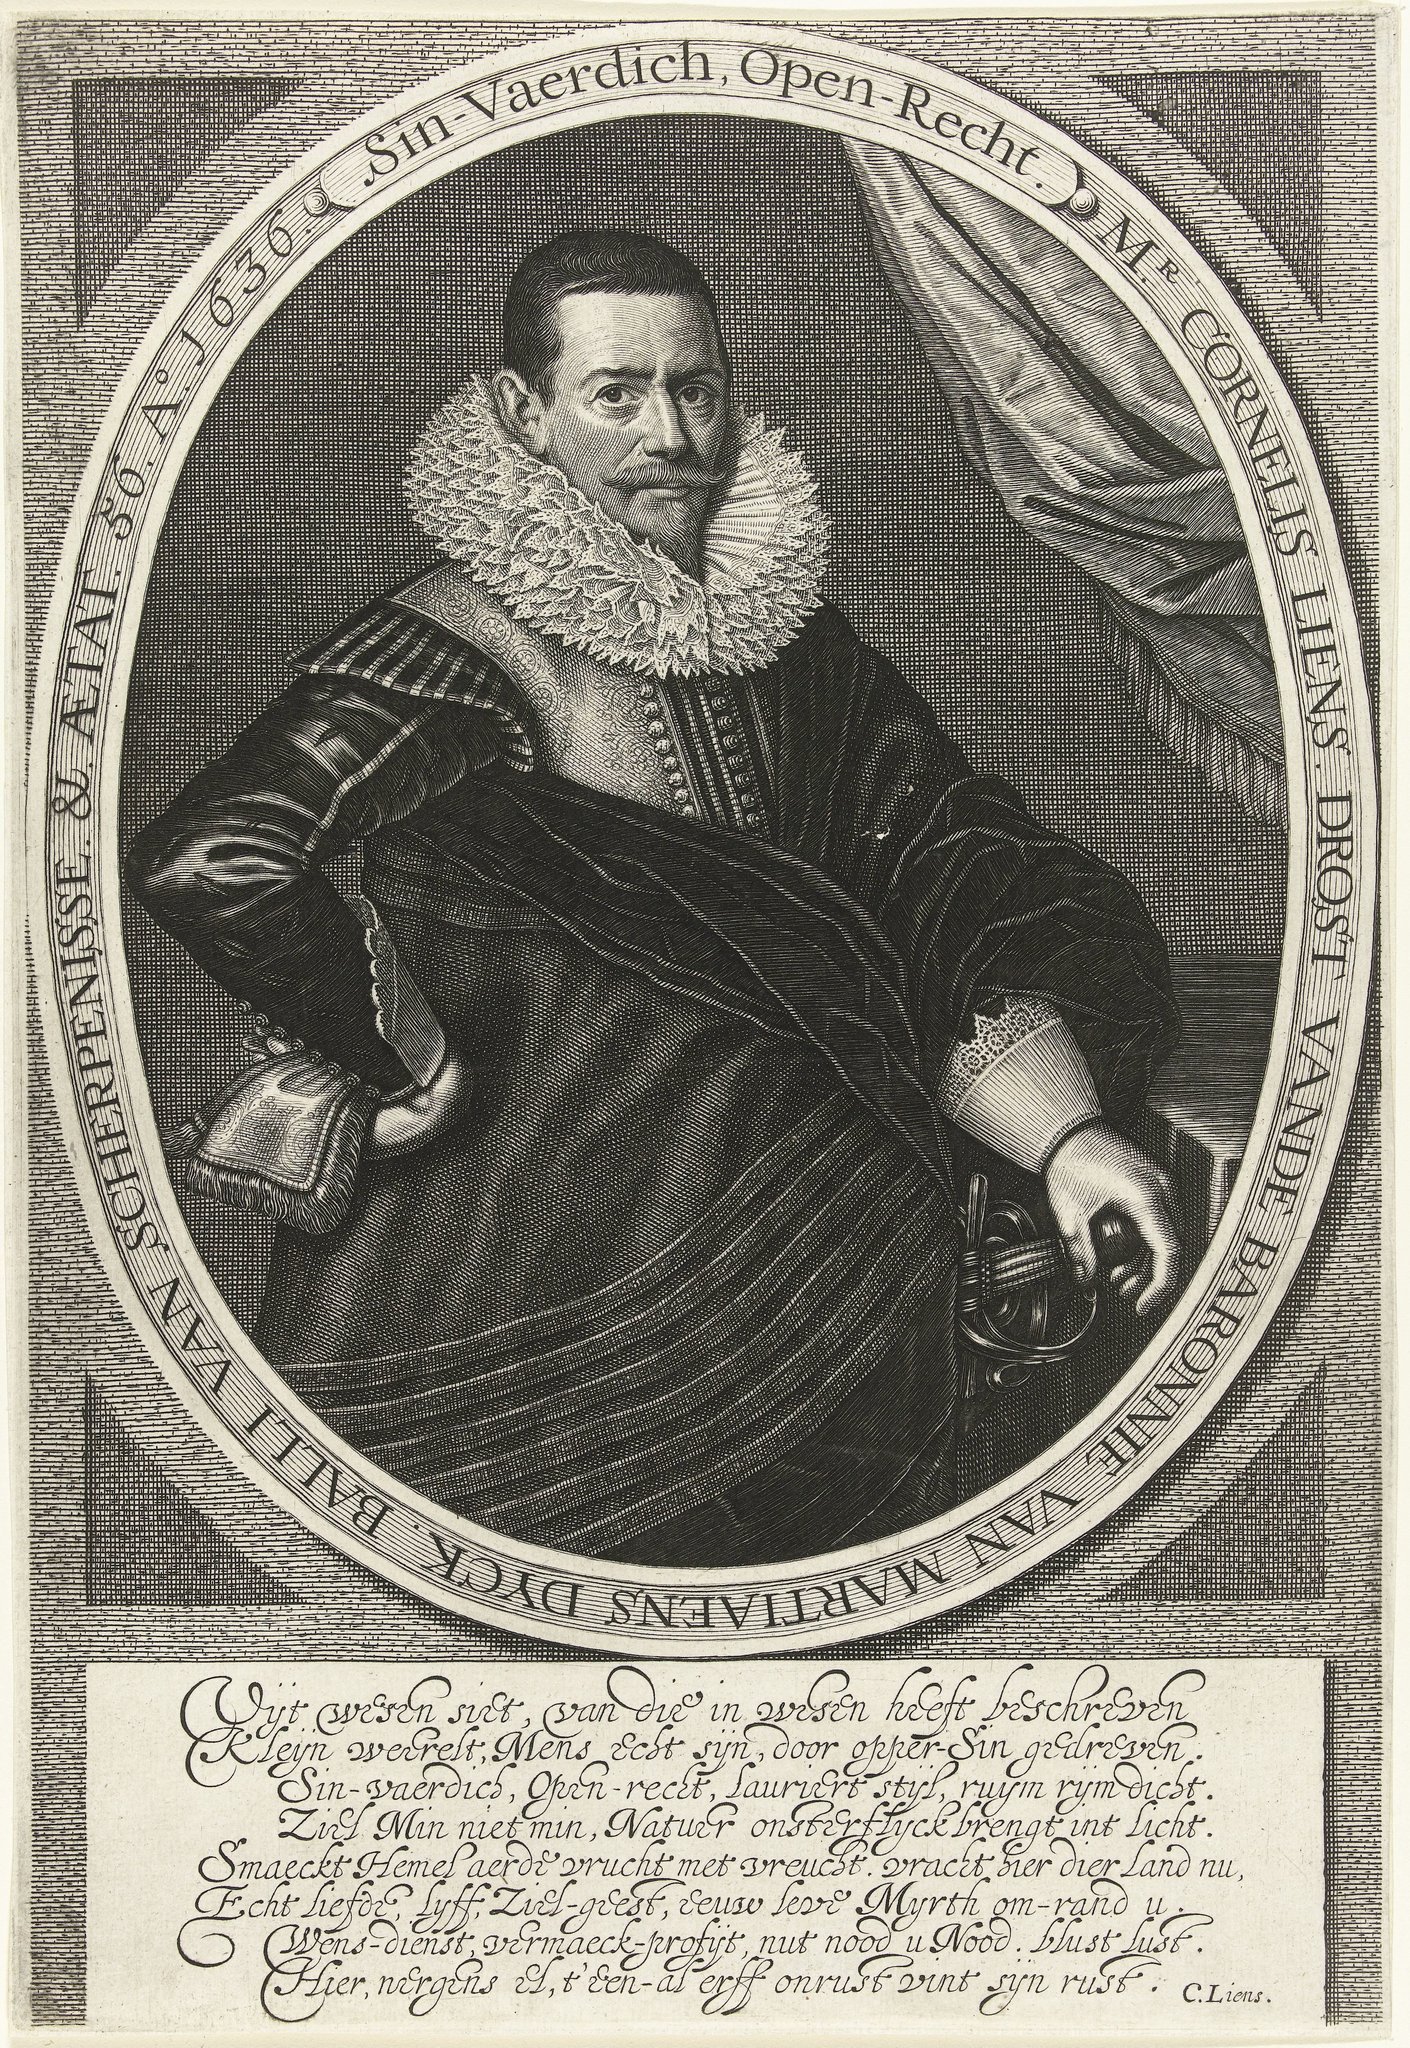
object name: print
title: Portret van Cornelis Liens op 56-jarige leeftijd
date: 1636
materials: paper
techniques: engraving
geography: delft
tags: cornelis liens, bailiff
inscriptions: date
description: Portret van Cornelis Liens op 56-jarige leeftijd, staand ten halven lijve in kleding die past bij zijn status als drost en baljuw. Ovale omlijsting, daaronder Nederlands vers in acht regels.